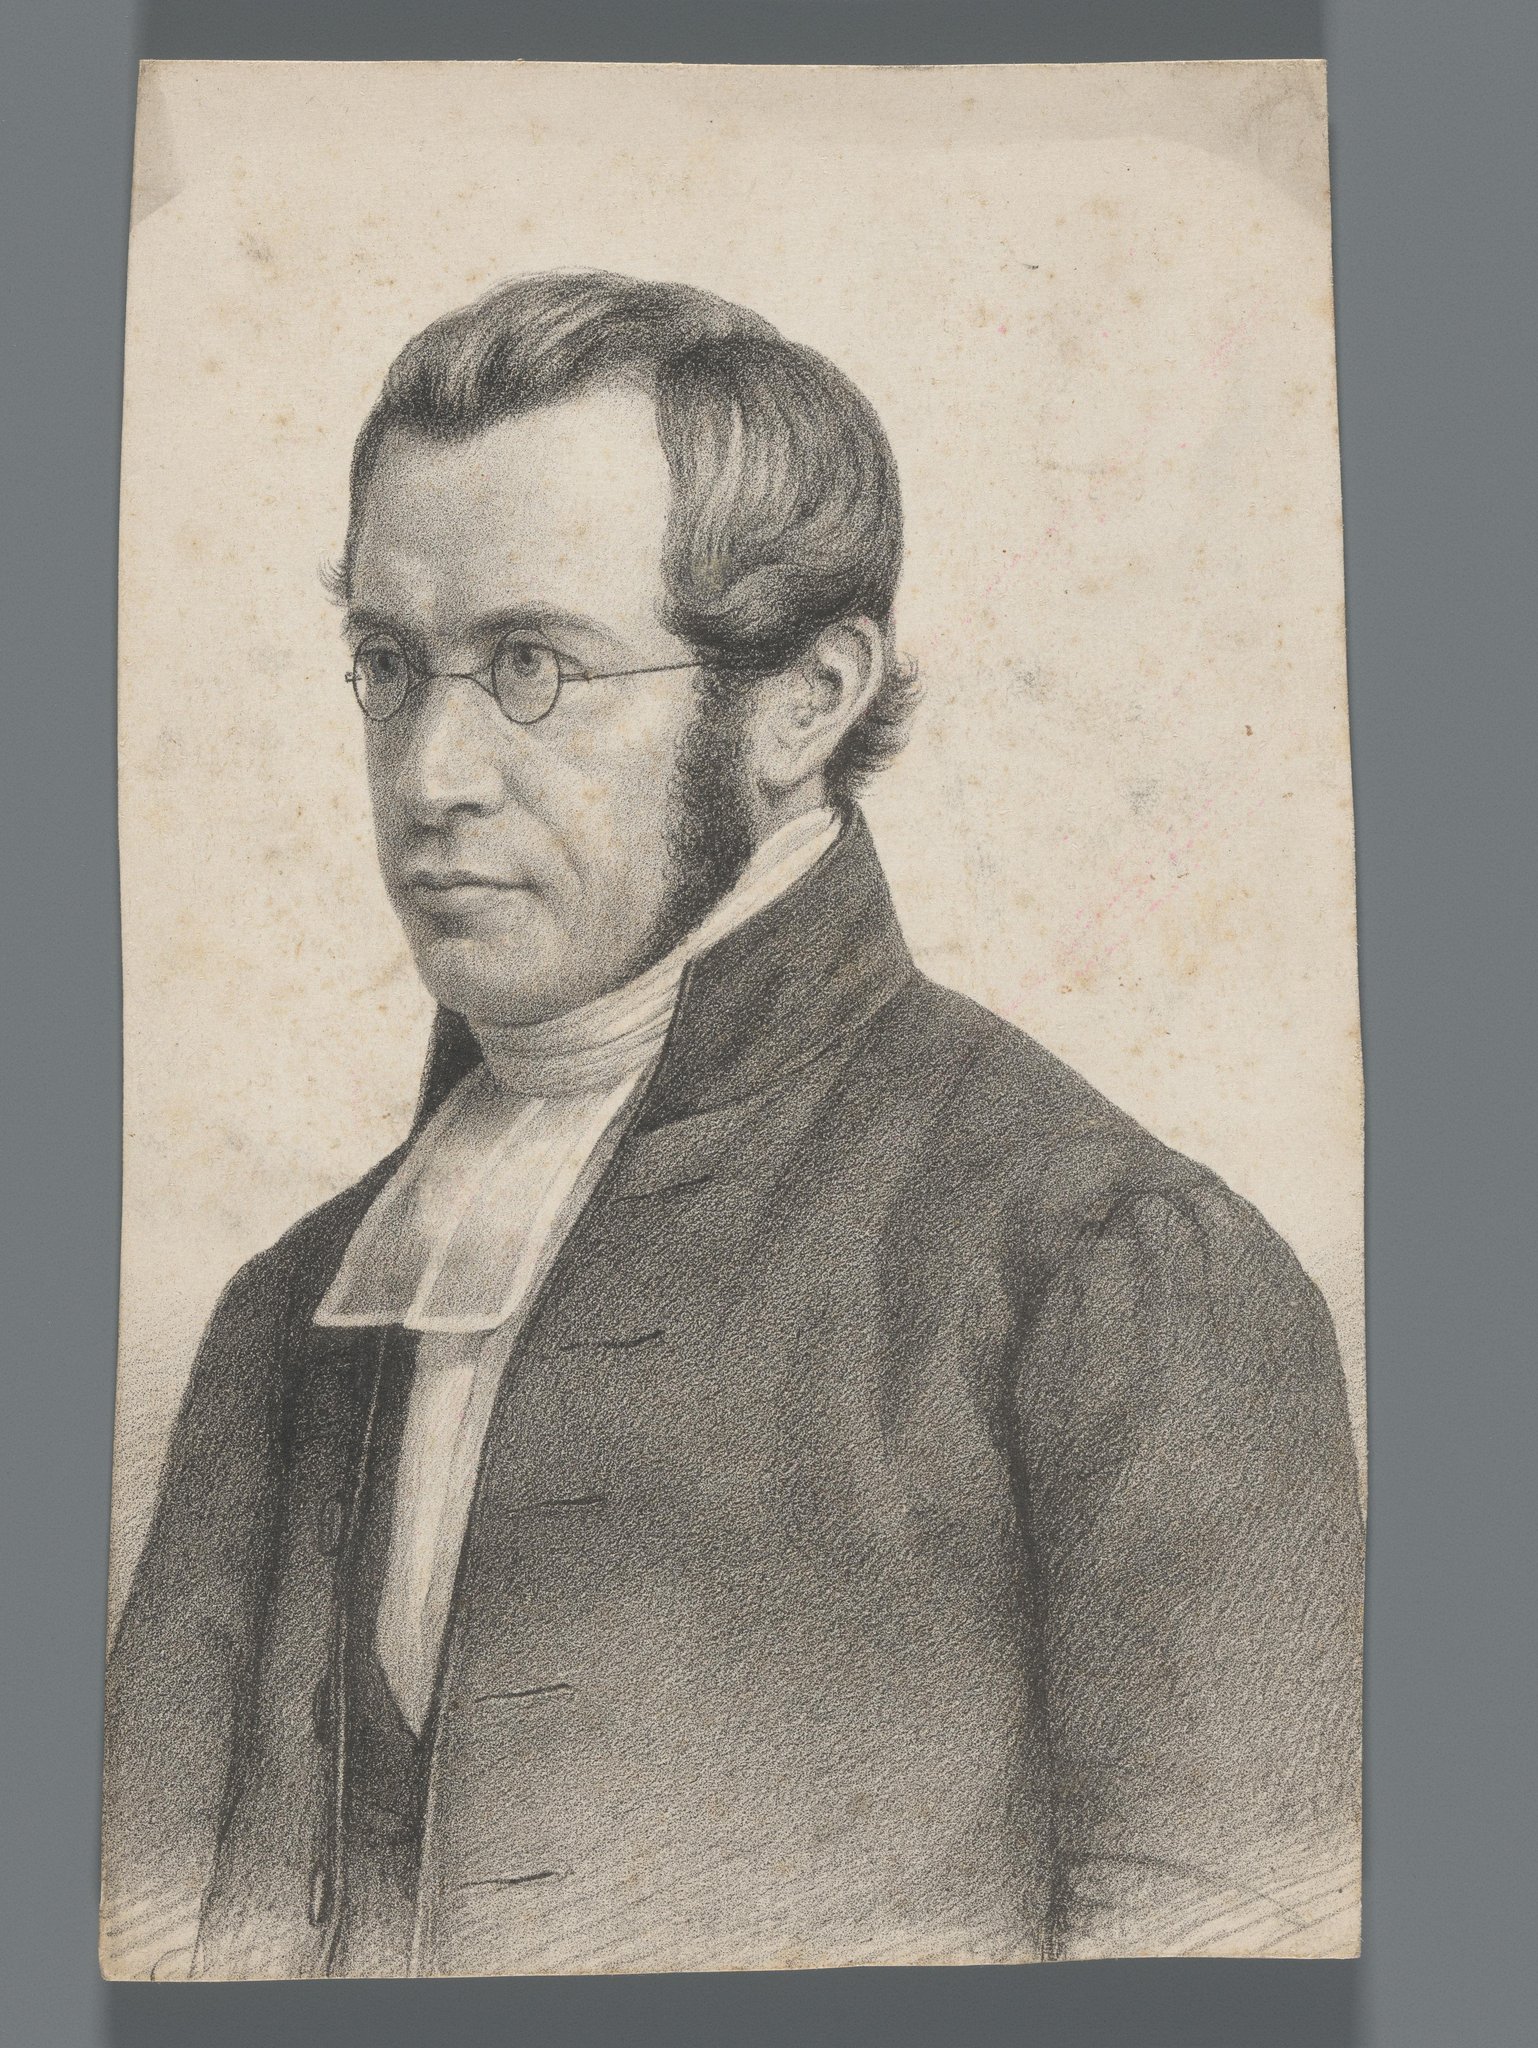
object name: print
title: Portret van een onbekende man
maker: Anonymous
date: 1810-1880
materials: paper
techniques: lithograph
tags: anonymous historical person portrayed